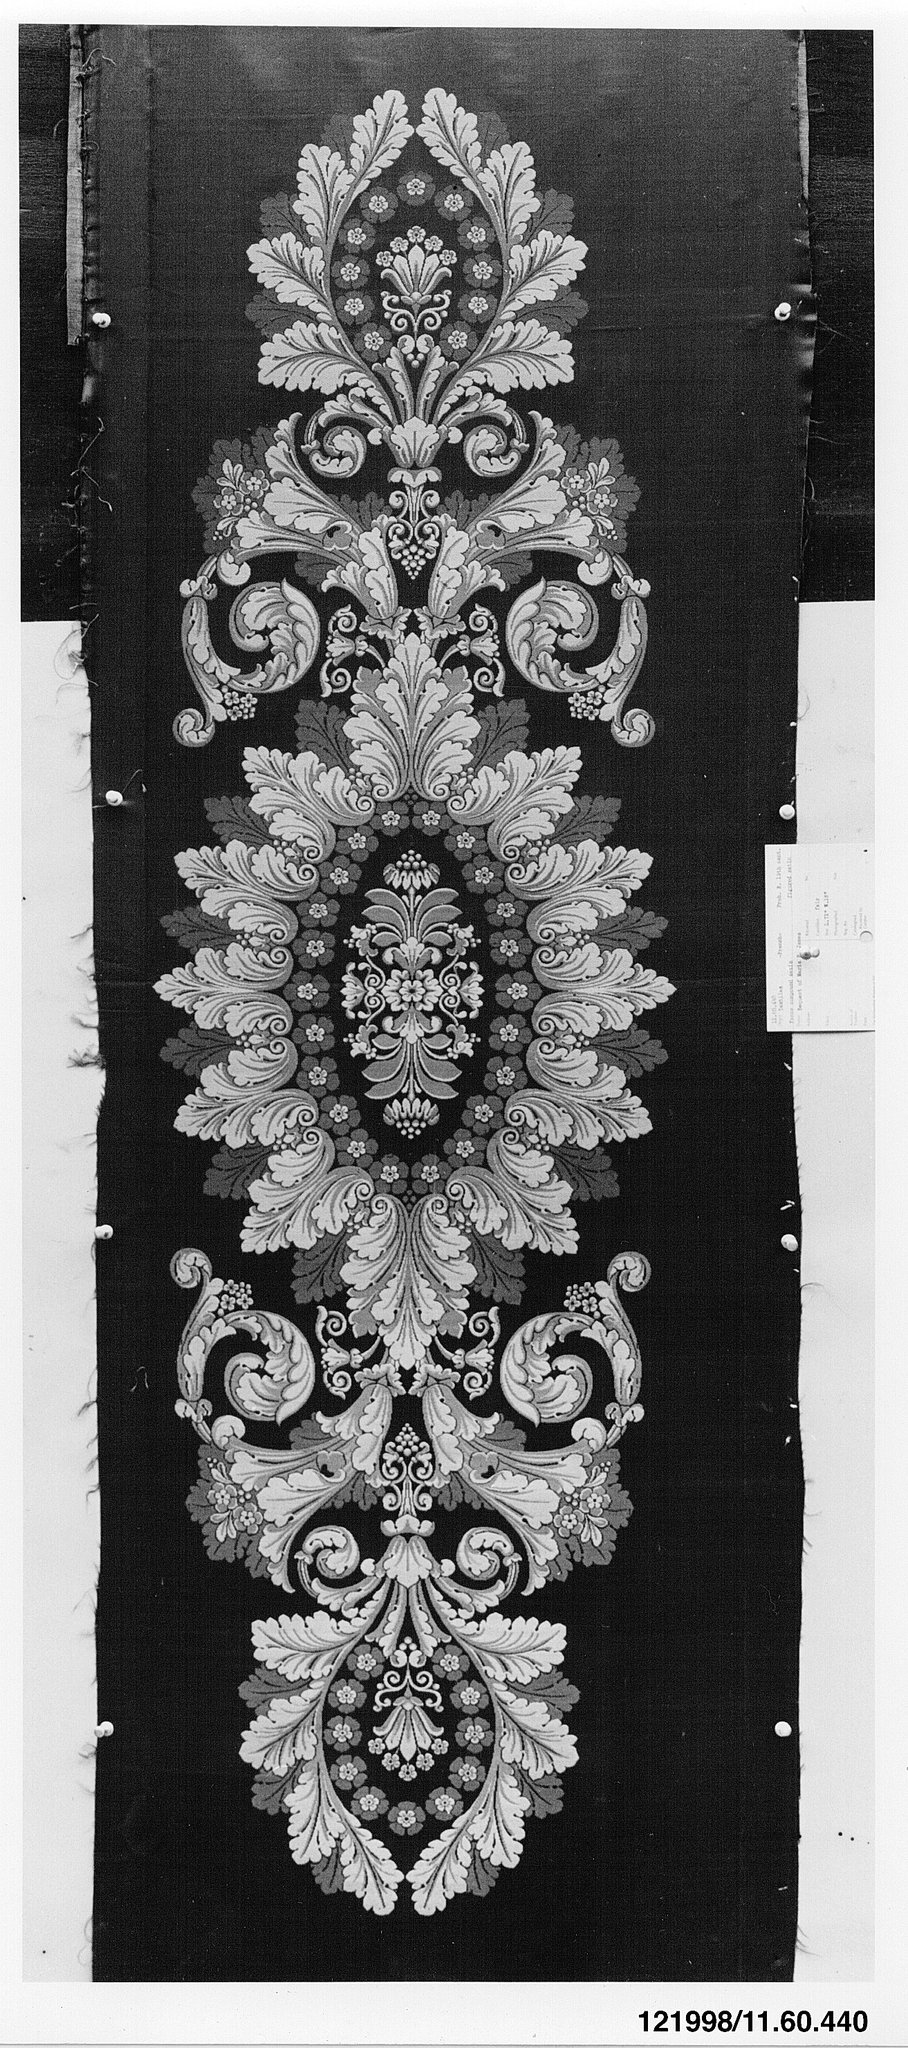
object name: piece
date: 1801-1833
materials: silk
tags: flowers,leaves